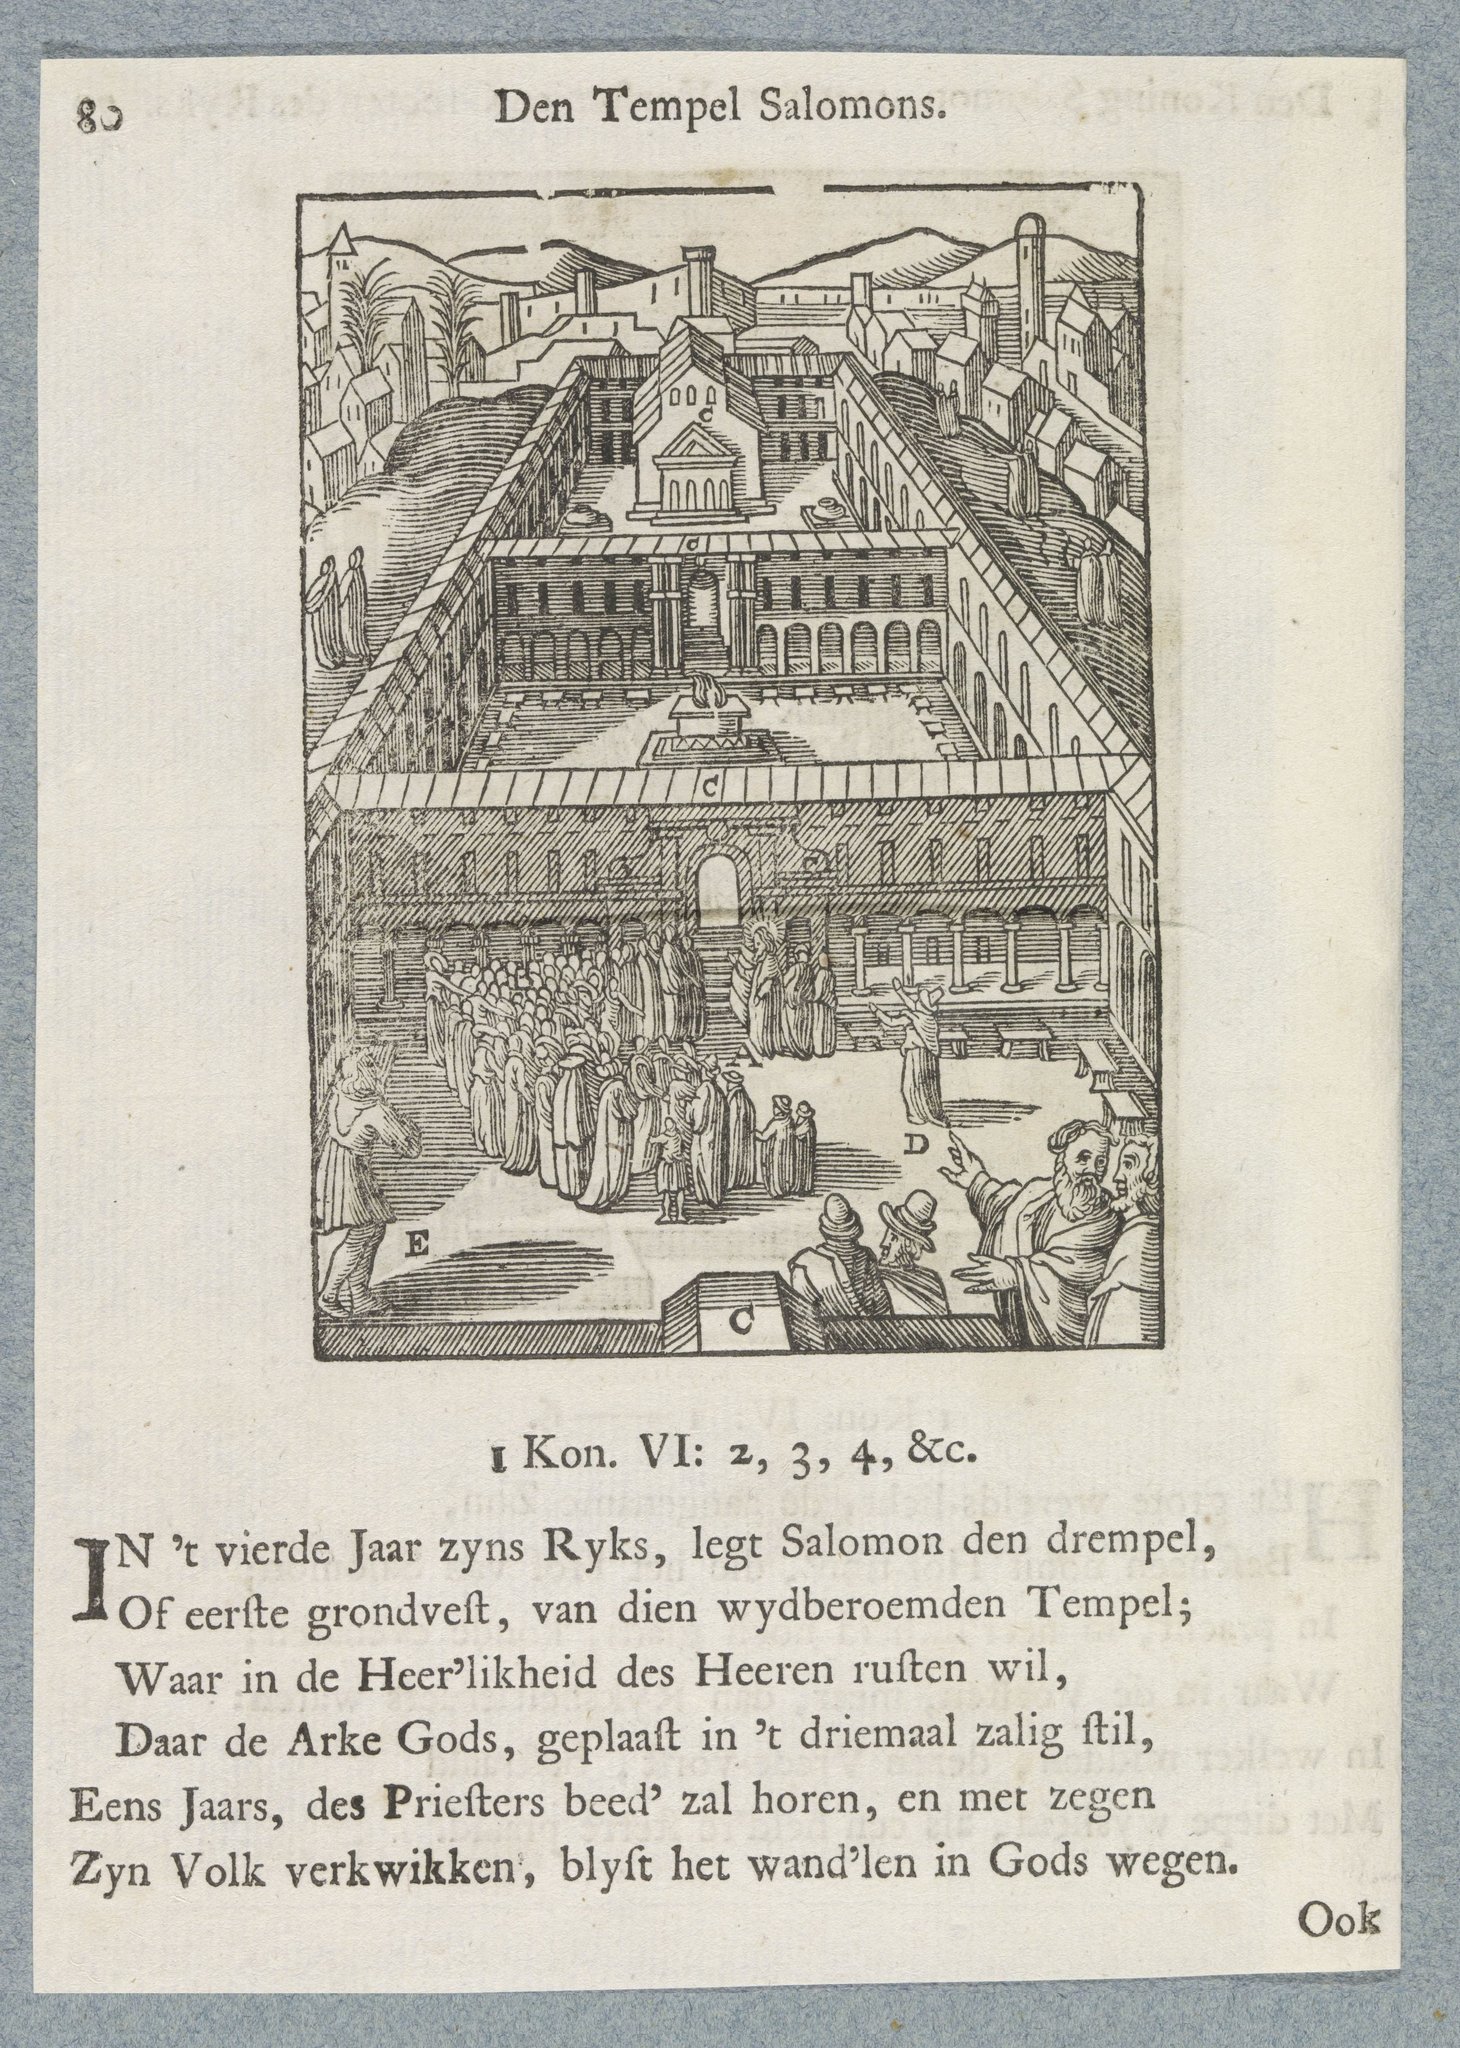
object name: album leaf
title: Den tempel Salomons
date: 1629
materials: paper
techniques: letterpress printing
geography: amsterdam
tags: the praying pharisee and the repentant publican in the temple (luke 18:10-14), temple of solomon (1 kings 5-9; 2 chronicles 2-7)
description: De prent is afkomstig uit: Bybels Lusthof. Amsterdam, J. Klooster, 1740. Ze werd voor het eerst gebruikt in: Der Zielen Lust-hof. Leuven, I.Jacbosz voor P.J. Paets [= Amsterdam, P.J. Paets], 1629. De voorstelling is gekopieerd naar een prent van Antonie II Wierix voor: Nadal, Jerónimo. Evangelicae Historiae Imagines. Antwerpen, M. Nutius, 1593.